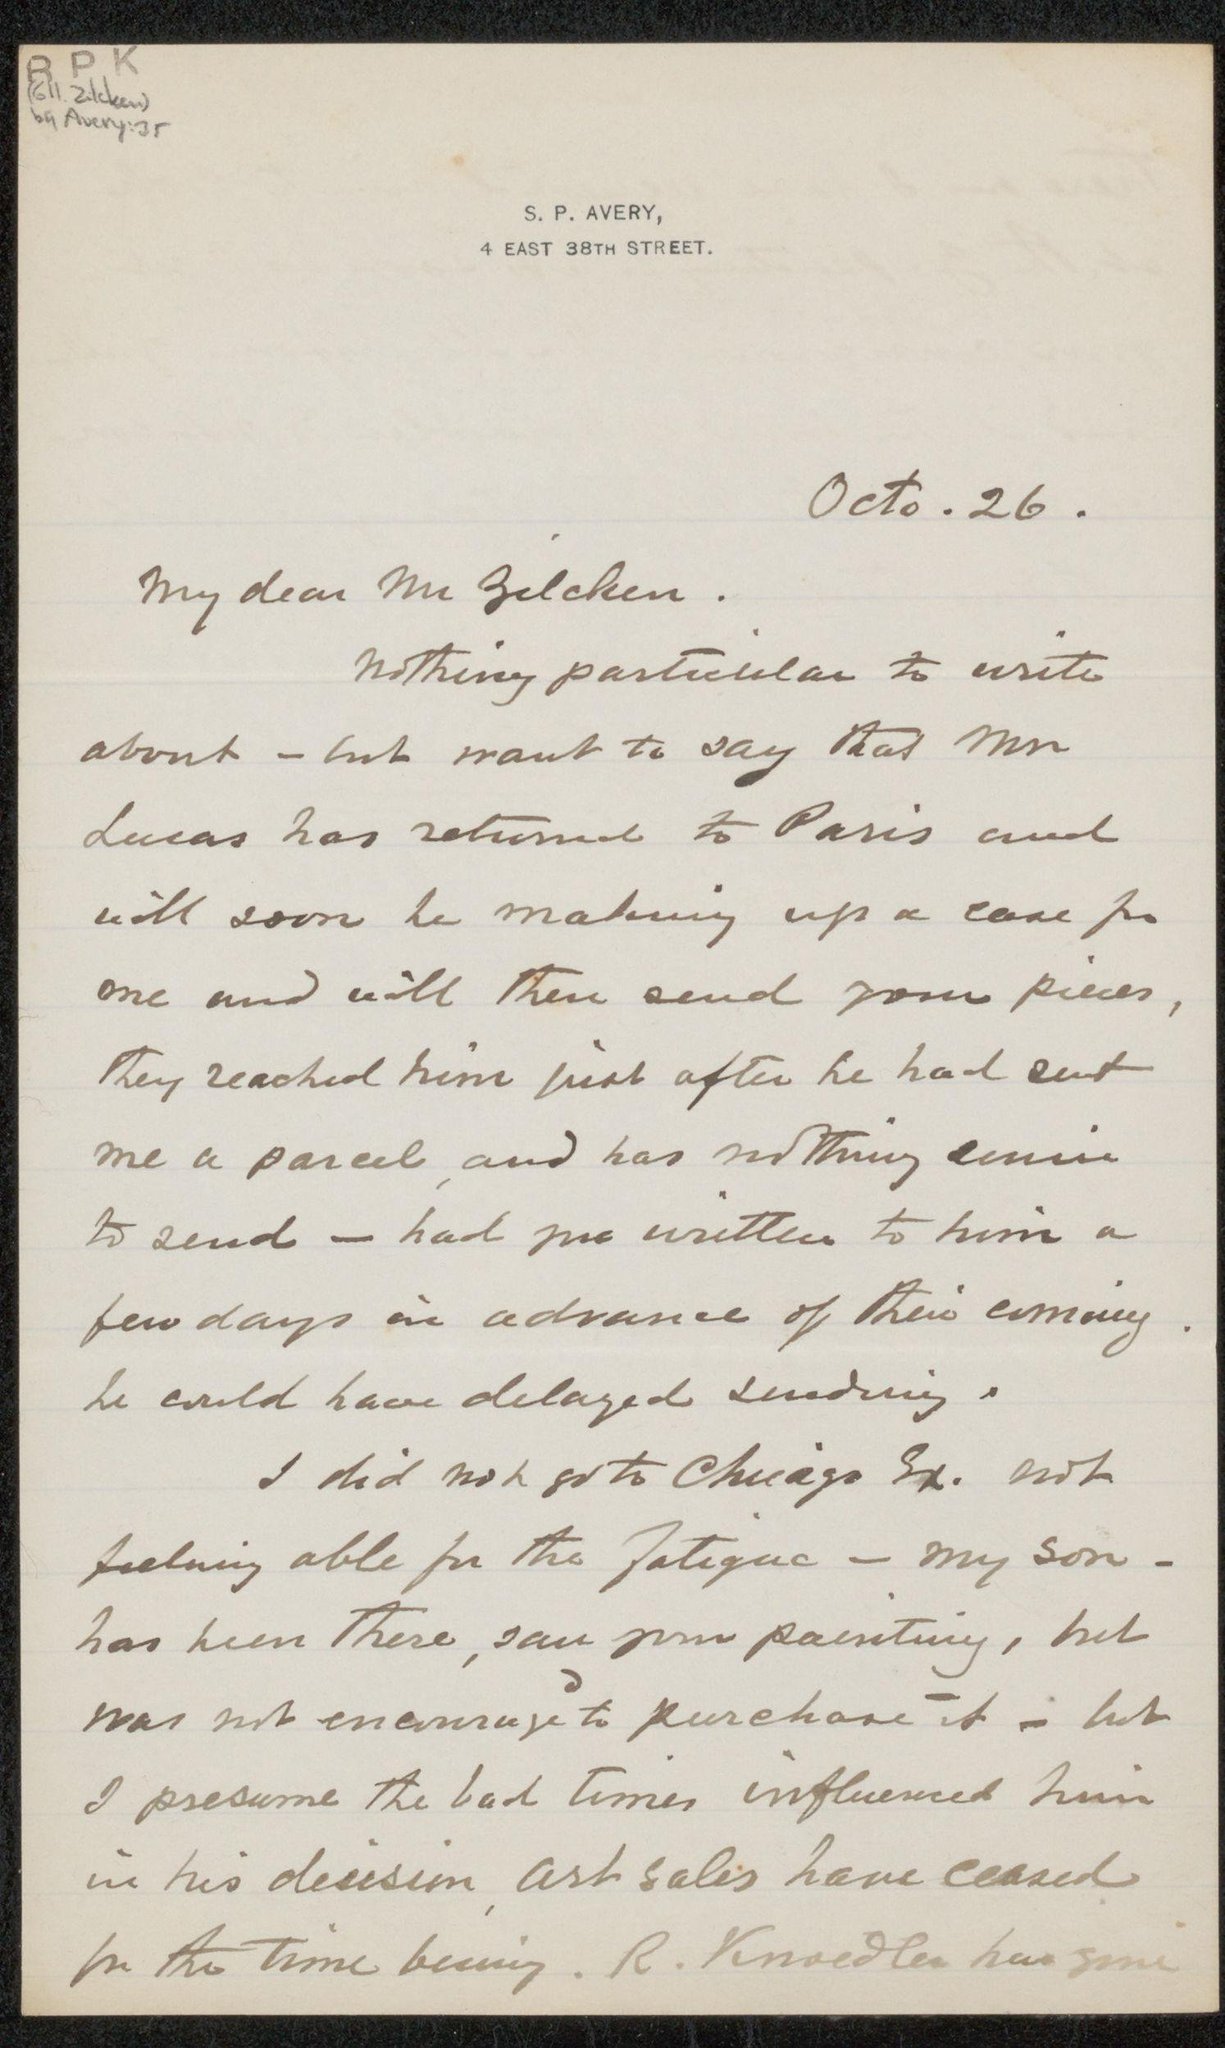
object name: letter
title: Brief aan Philip Zilcken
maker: samuel putnam avery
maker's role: verzamelaar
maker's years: 1822-1904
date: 1832-1904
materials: ink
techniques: pen, printing, writing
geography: new york city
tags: arnhem, painter, print maker, draughtsman, anton mauve, the hague, philip zilcken, sending and receiving postal matter, temporary exhibition, 'salon'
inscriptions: collector's mark: ‘RPK’